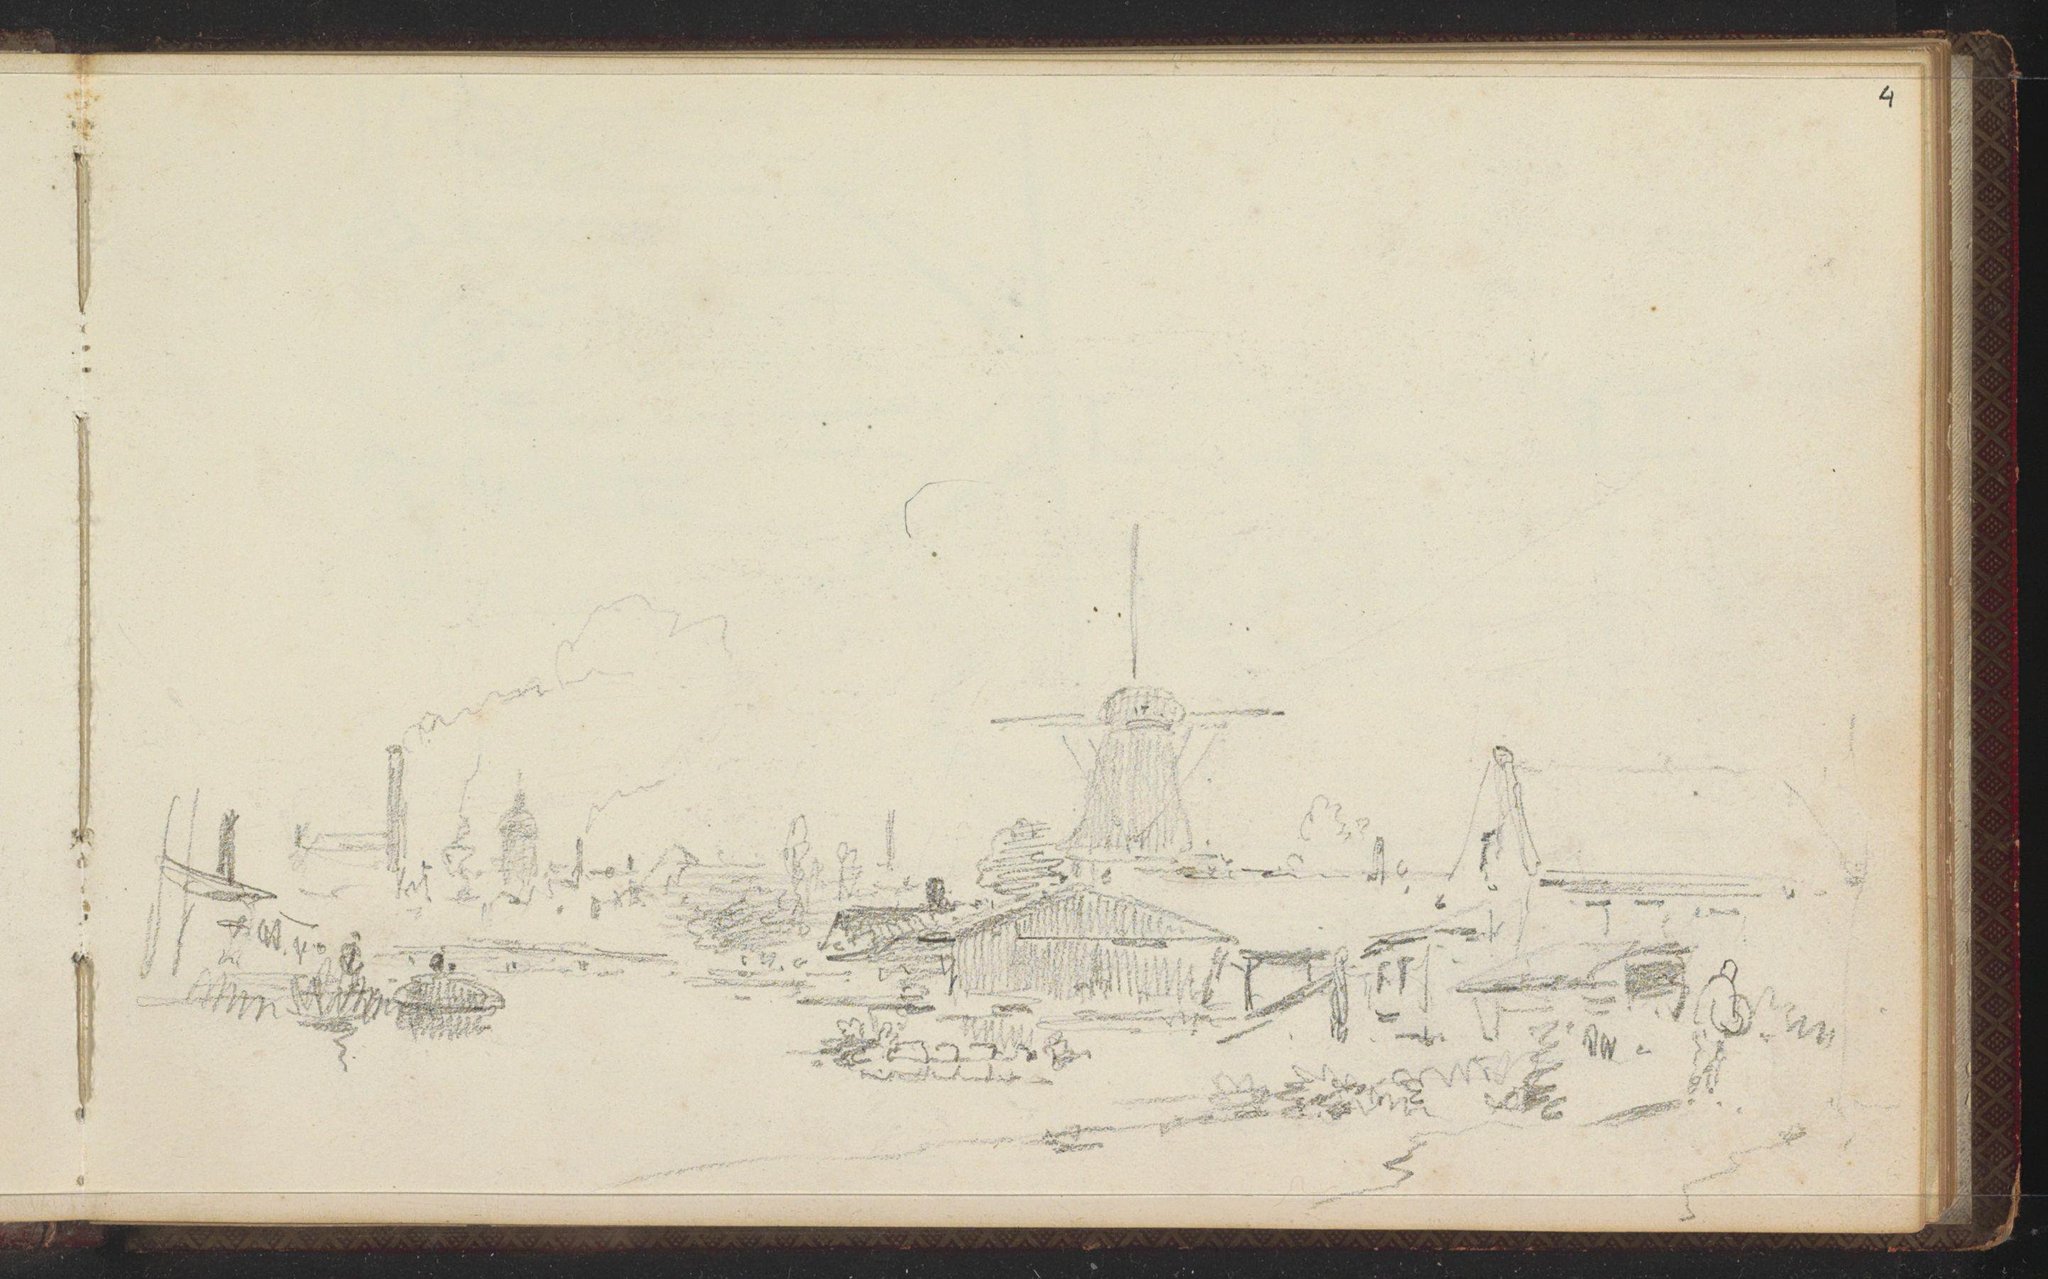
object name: sketchbook leaf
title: Stadsgezicht, mogelijk Kampen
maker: adrianus eversen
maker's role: draughtsman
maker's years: 1818-1897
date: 1828-1897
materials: paper, pencil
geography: netherlands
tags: city-view, and landscape with man-made constructions, river, windmill in landscape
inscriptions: kleurnotitie, handgeschreven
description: Stadsgezicht, mogelijk Kampen. Vooraan een rivier. In het midden een molen. Rechts een figuur bij een gebouw. Blad 4 recto uit een schetsboek met 52 bladen vervaardigd in de omgeving van Kampen, Hattem, Hoorn en Zwolle.